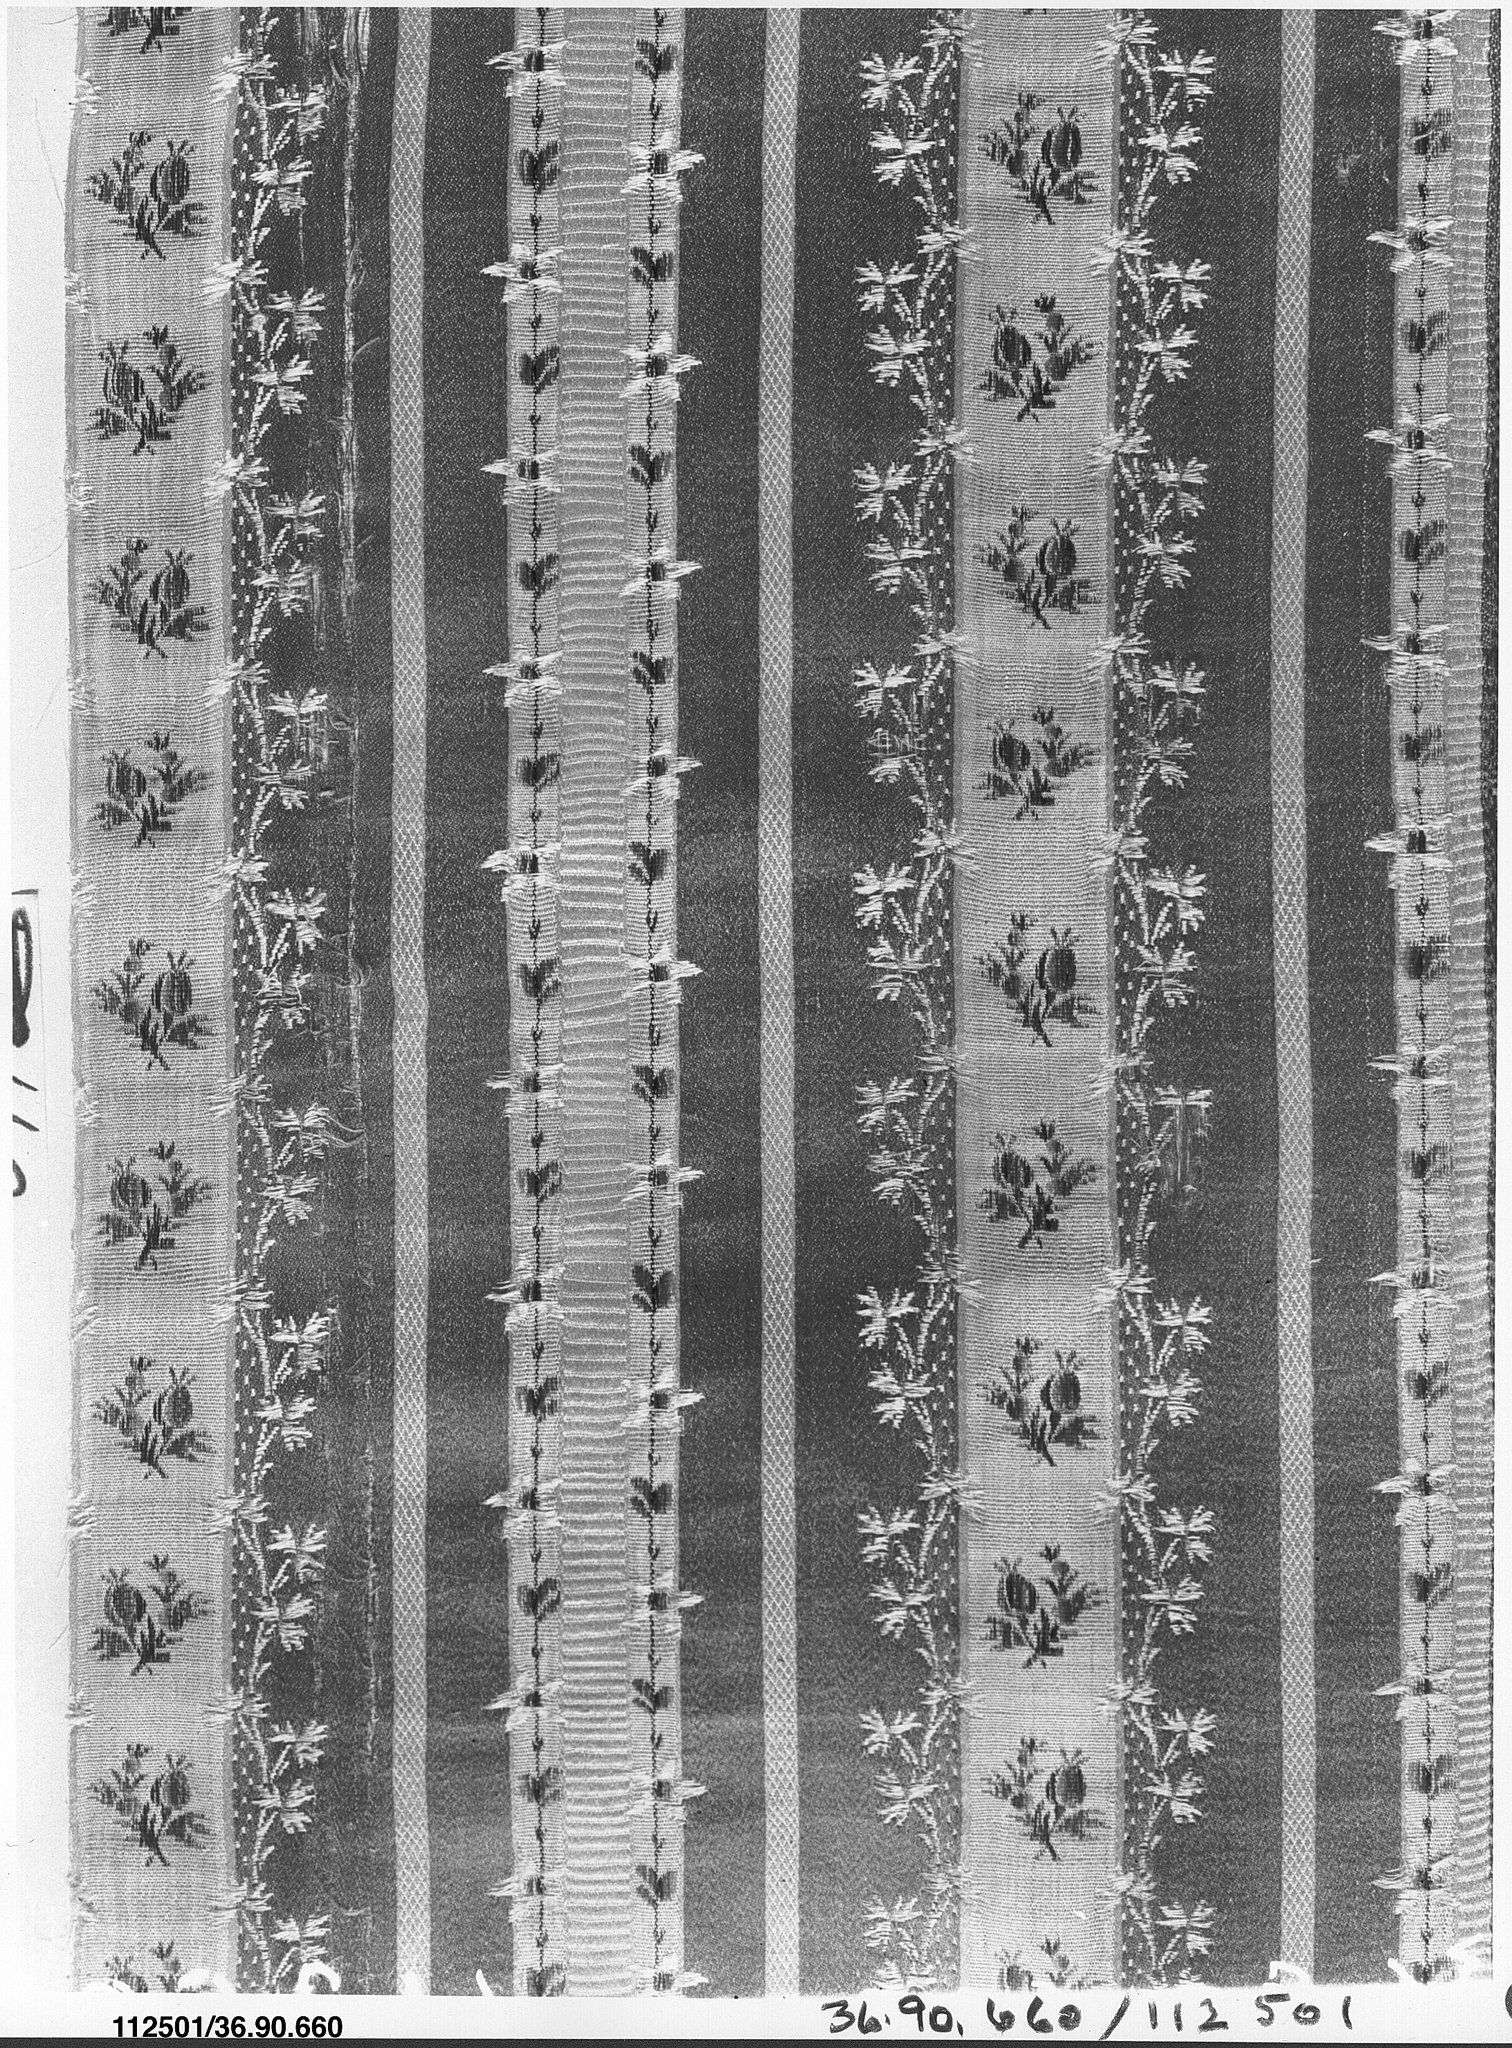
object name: piece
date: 1701-1800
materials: silk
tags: flowers,leaves